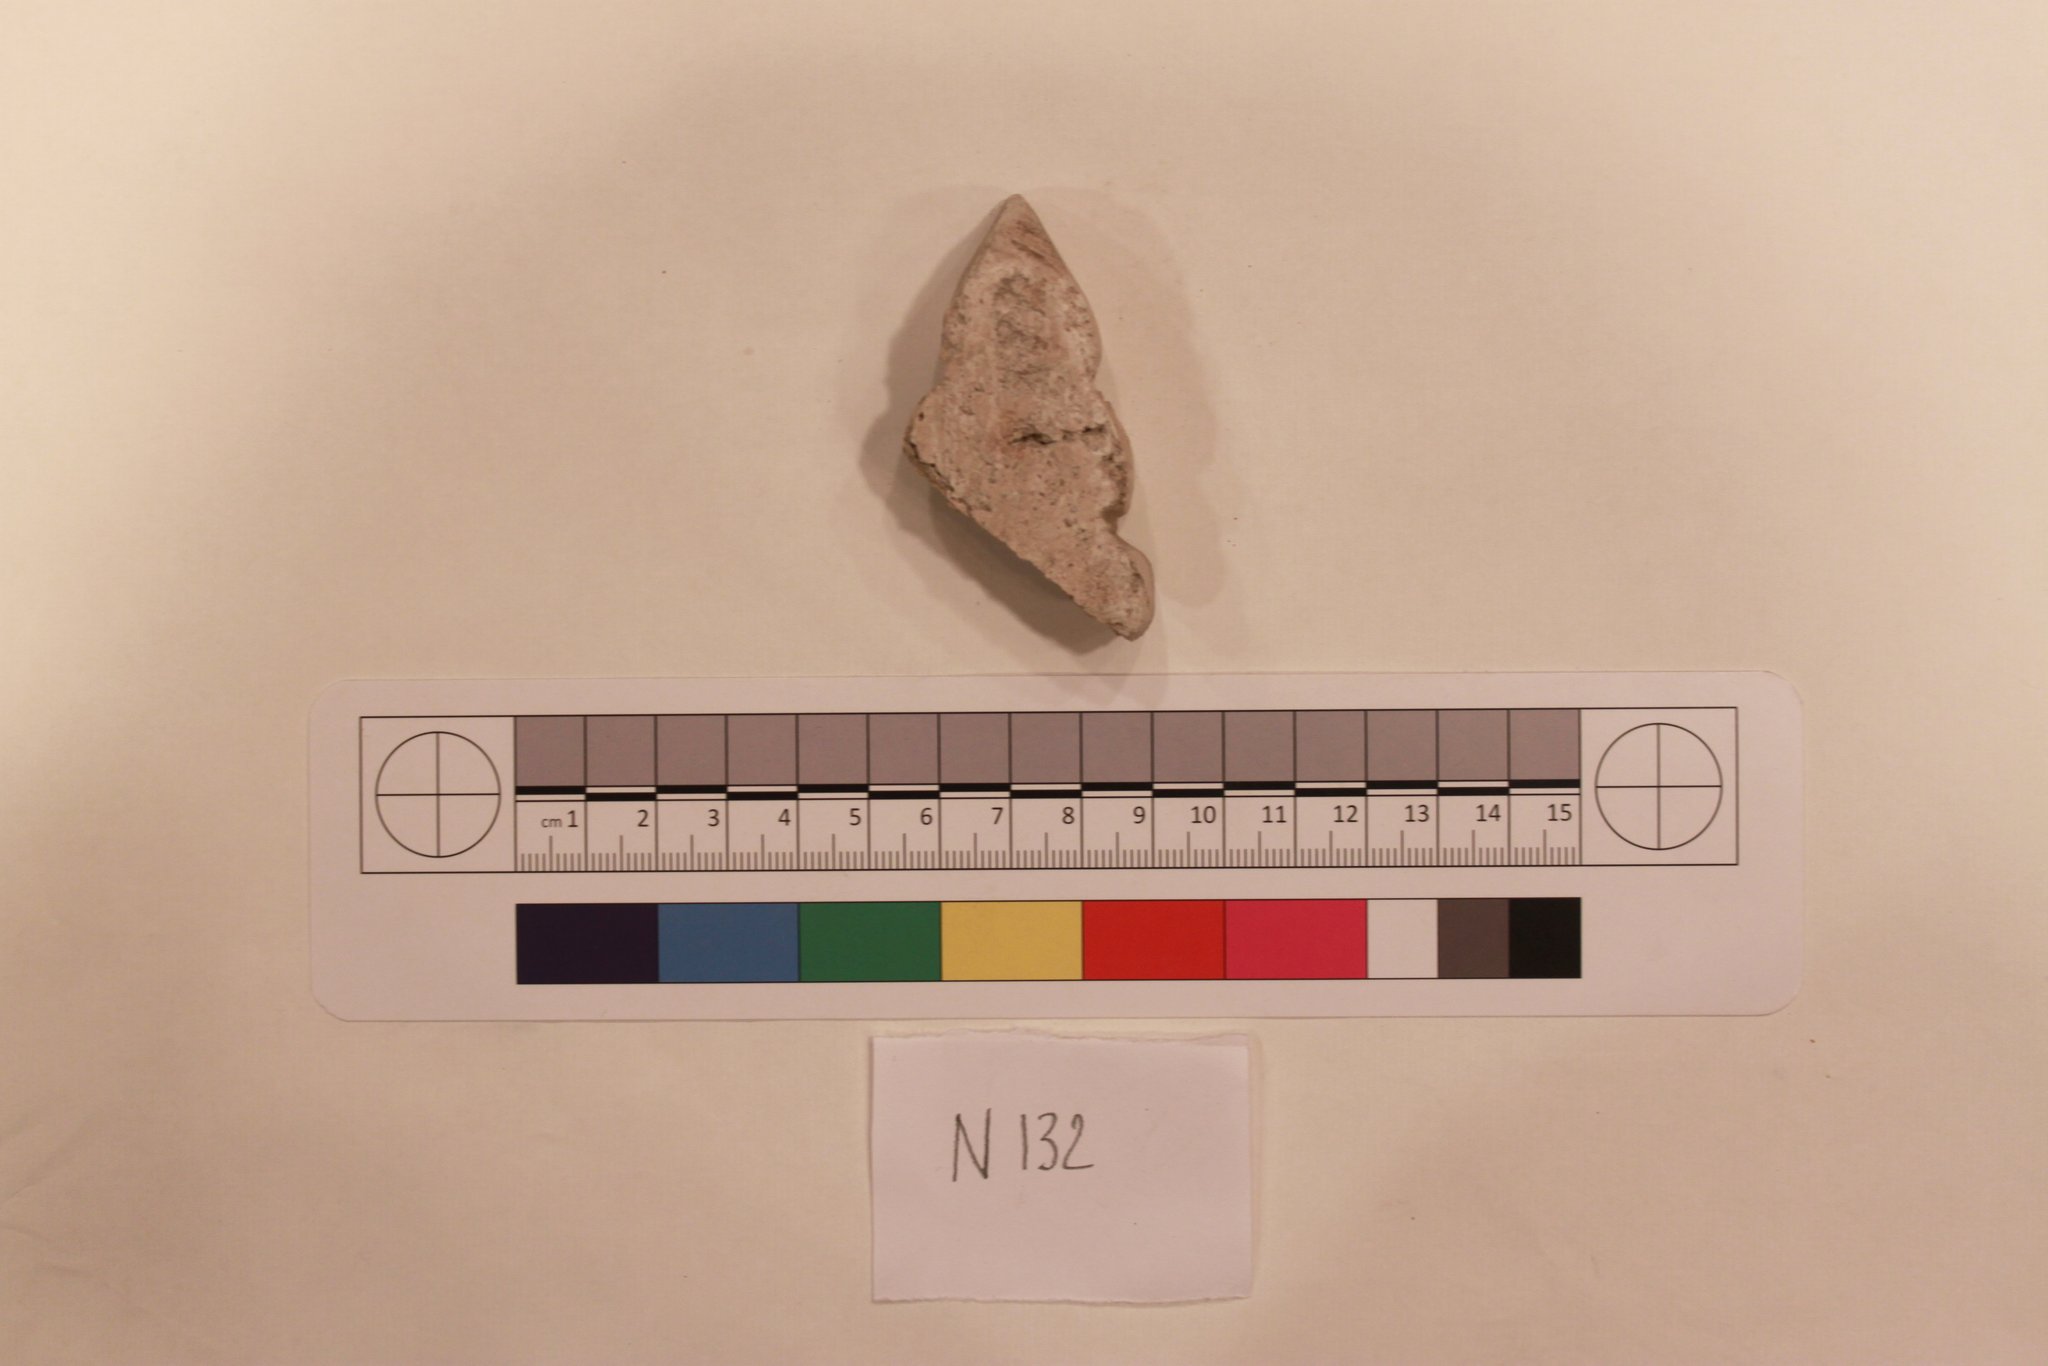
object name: fragment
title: Stucco Fragment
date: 701-1200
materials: plaster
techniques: carving, painting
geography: iran